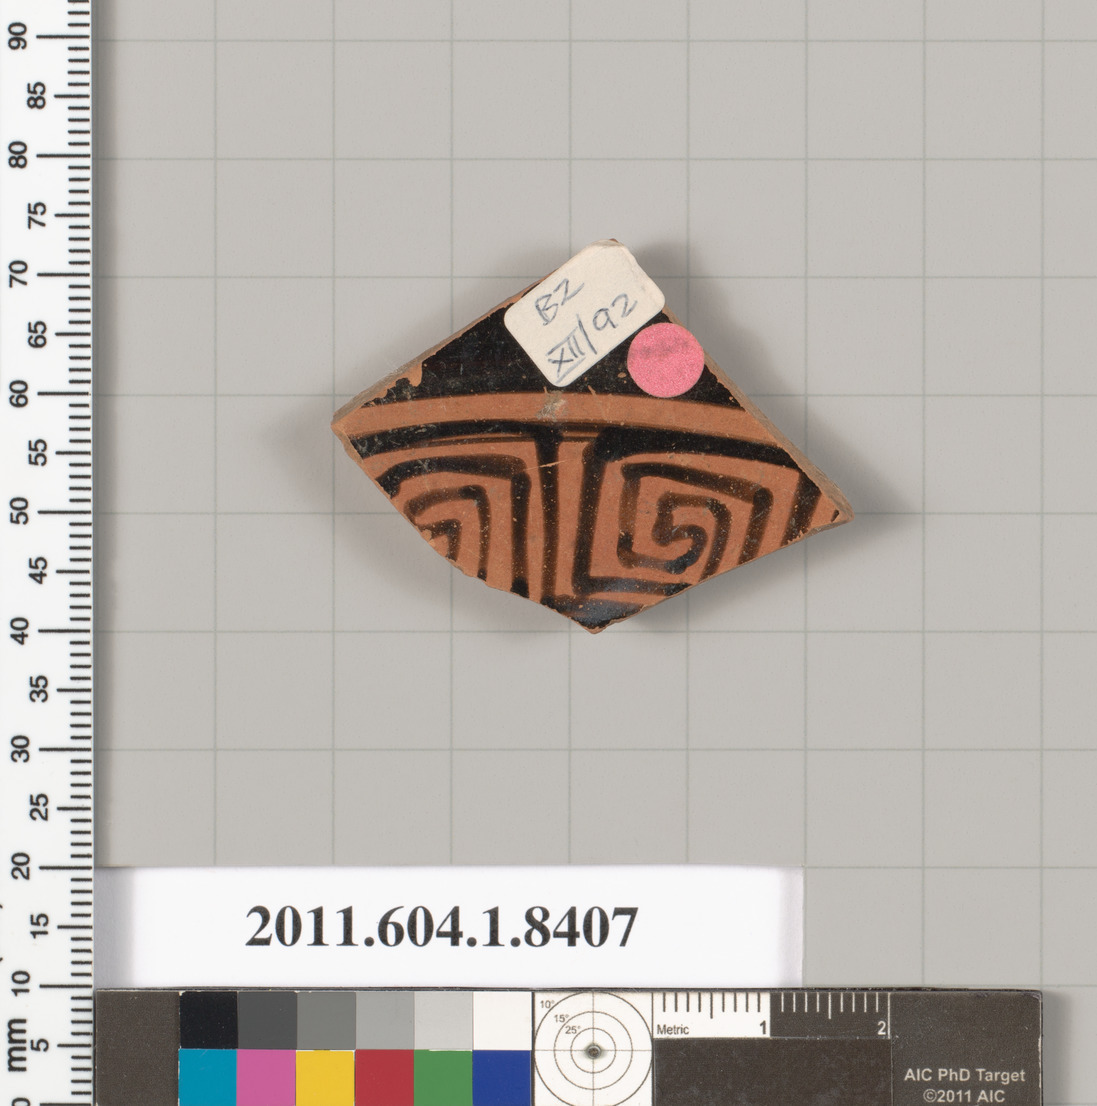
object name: kylix fragment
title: Terracotta fragment of a kylix (drinking cup)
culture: greek, attic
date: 375-351 BCE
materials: terracotta